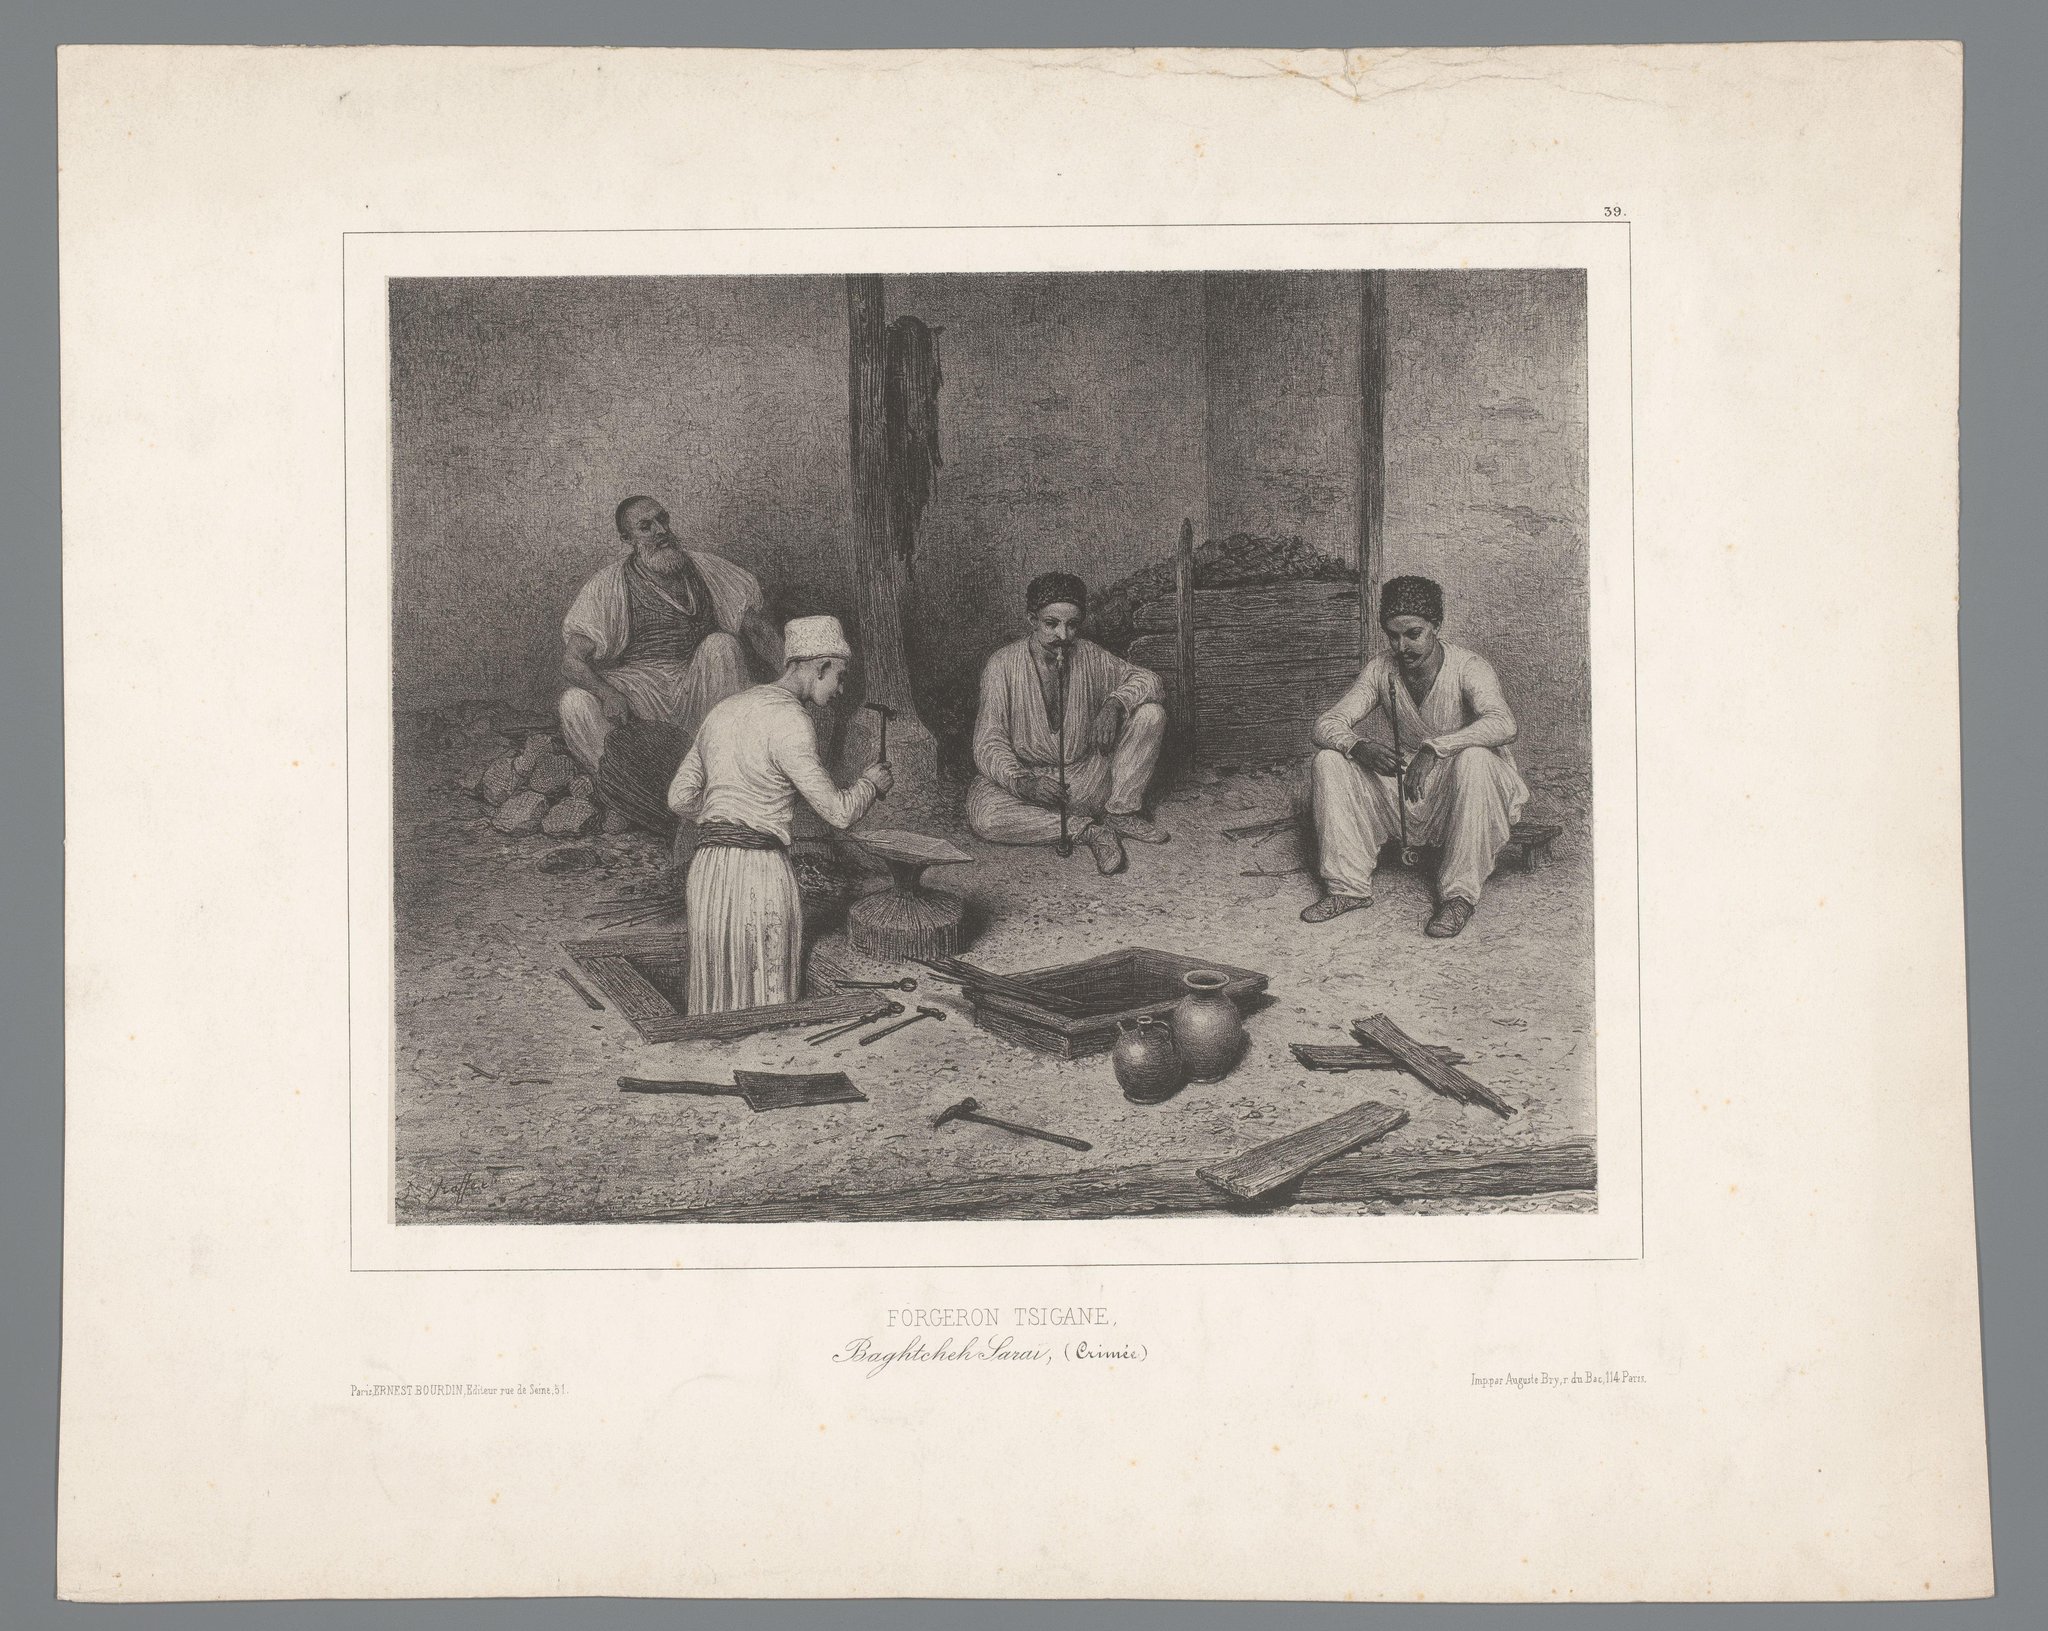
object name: print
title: Voyage dans la Russie Méridionale et la Crimée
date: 1840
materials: paper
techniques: lithograph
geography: paris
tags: pipe ~ tobacco, smith, blacksmith, bellows